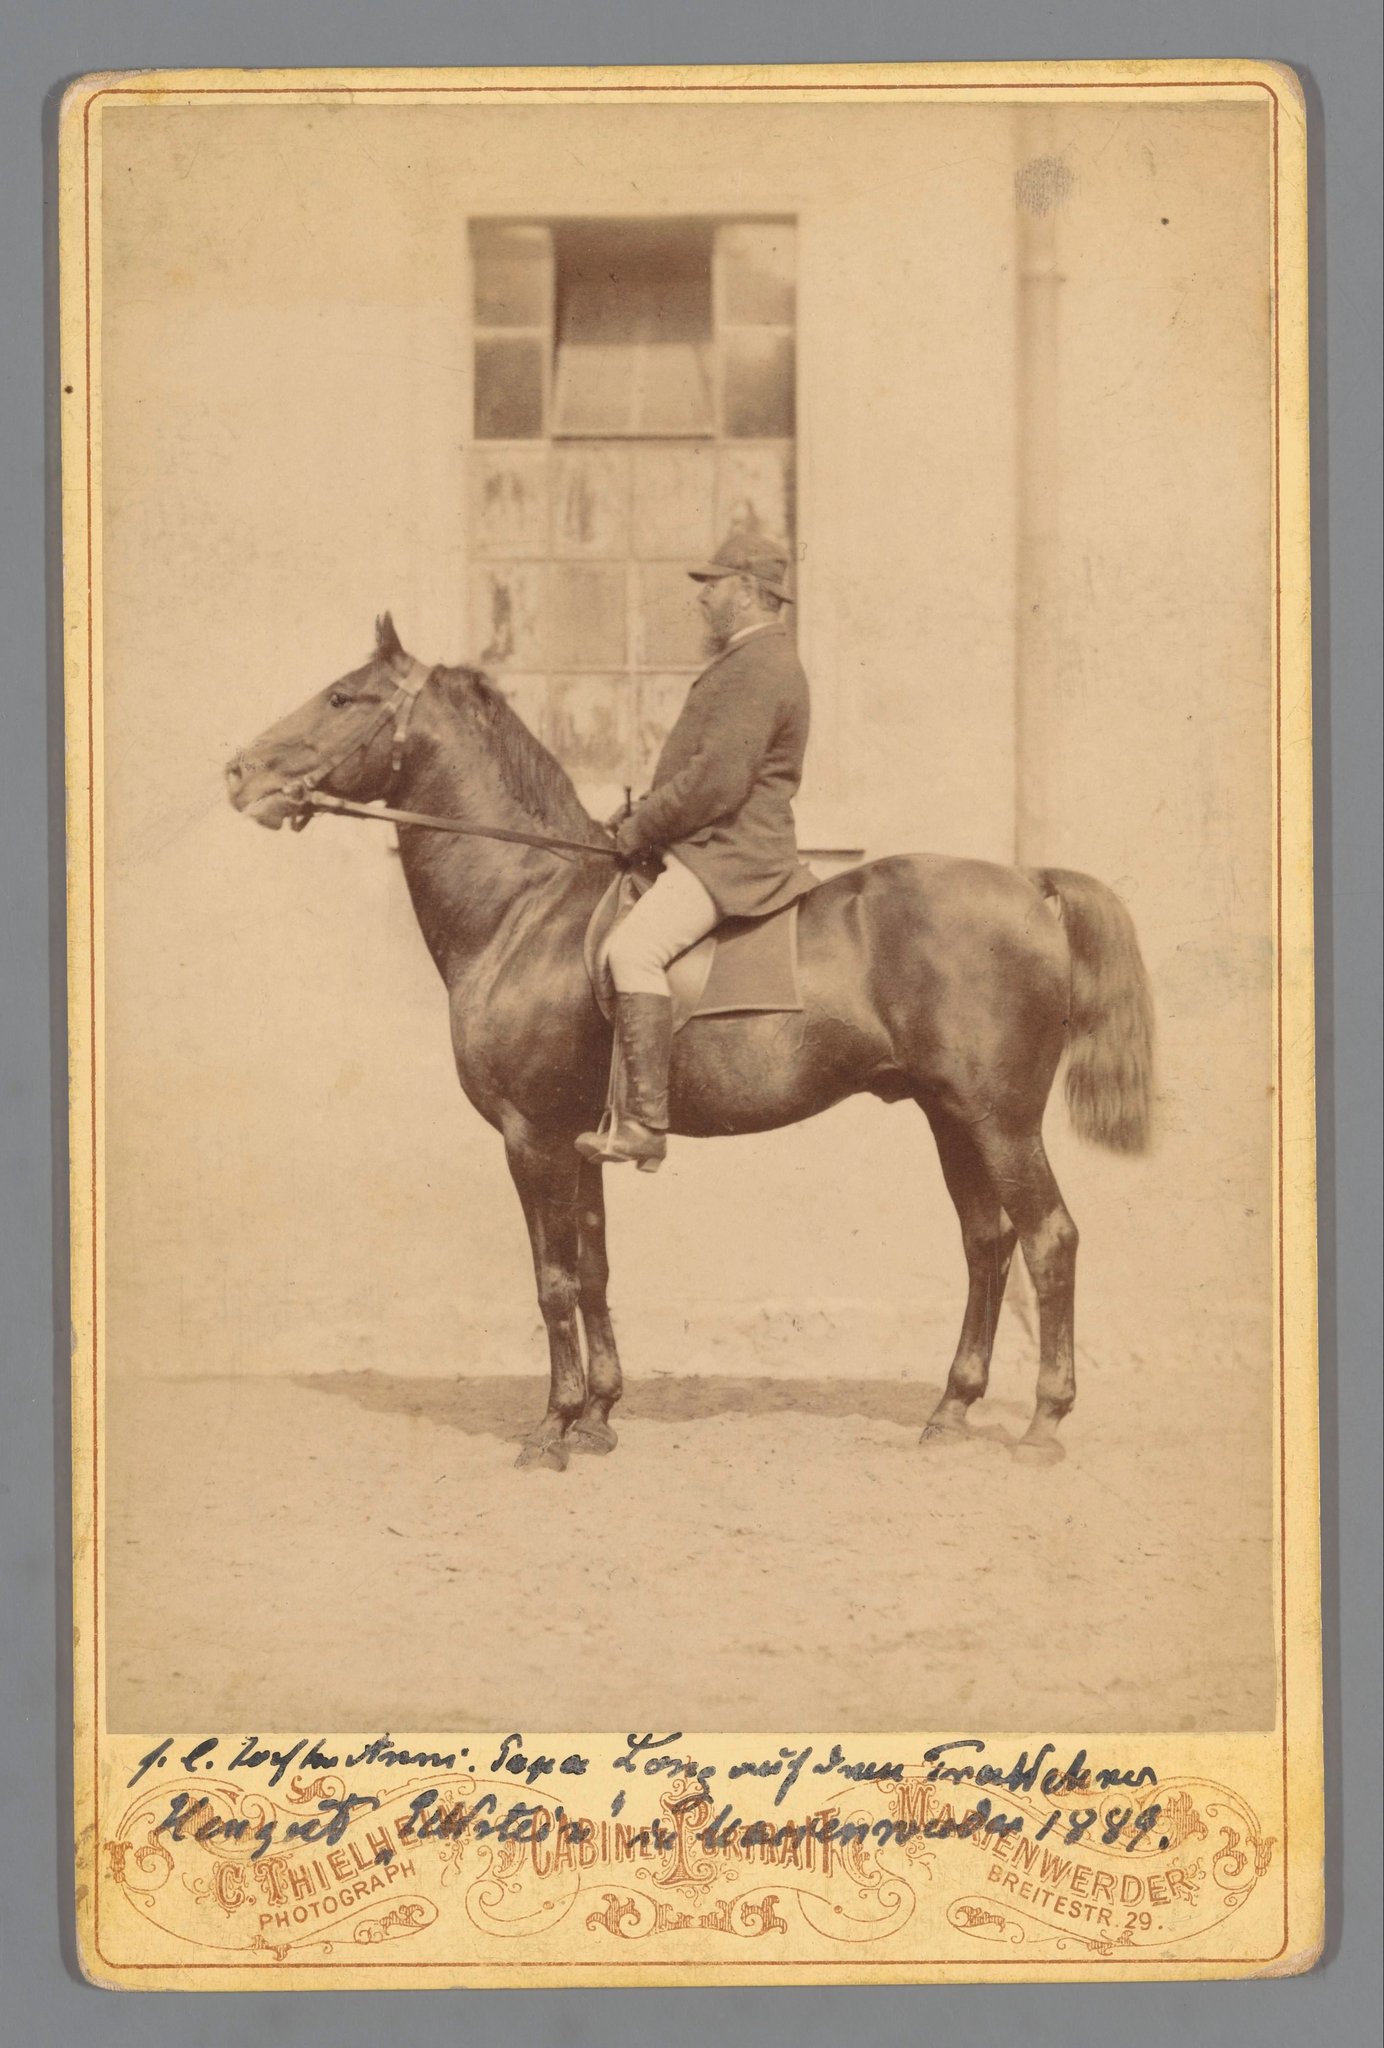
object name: photograph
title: Portret van een onbekende man op een paard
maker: carl thielheim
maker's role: fotograaf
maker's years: 1842-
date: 1889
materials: cardboard, photographic support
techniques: albumen print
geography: marienwerder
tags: riding a horse, ass, or mule; rider, horseman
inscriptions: inscription: ‘p. l. (...) 1889.’, inscription: ‘Atelier für portrait-und landschaftsphotographie. (...) platten für nachbestellung reservirt.’